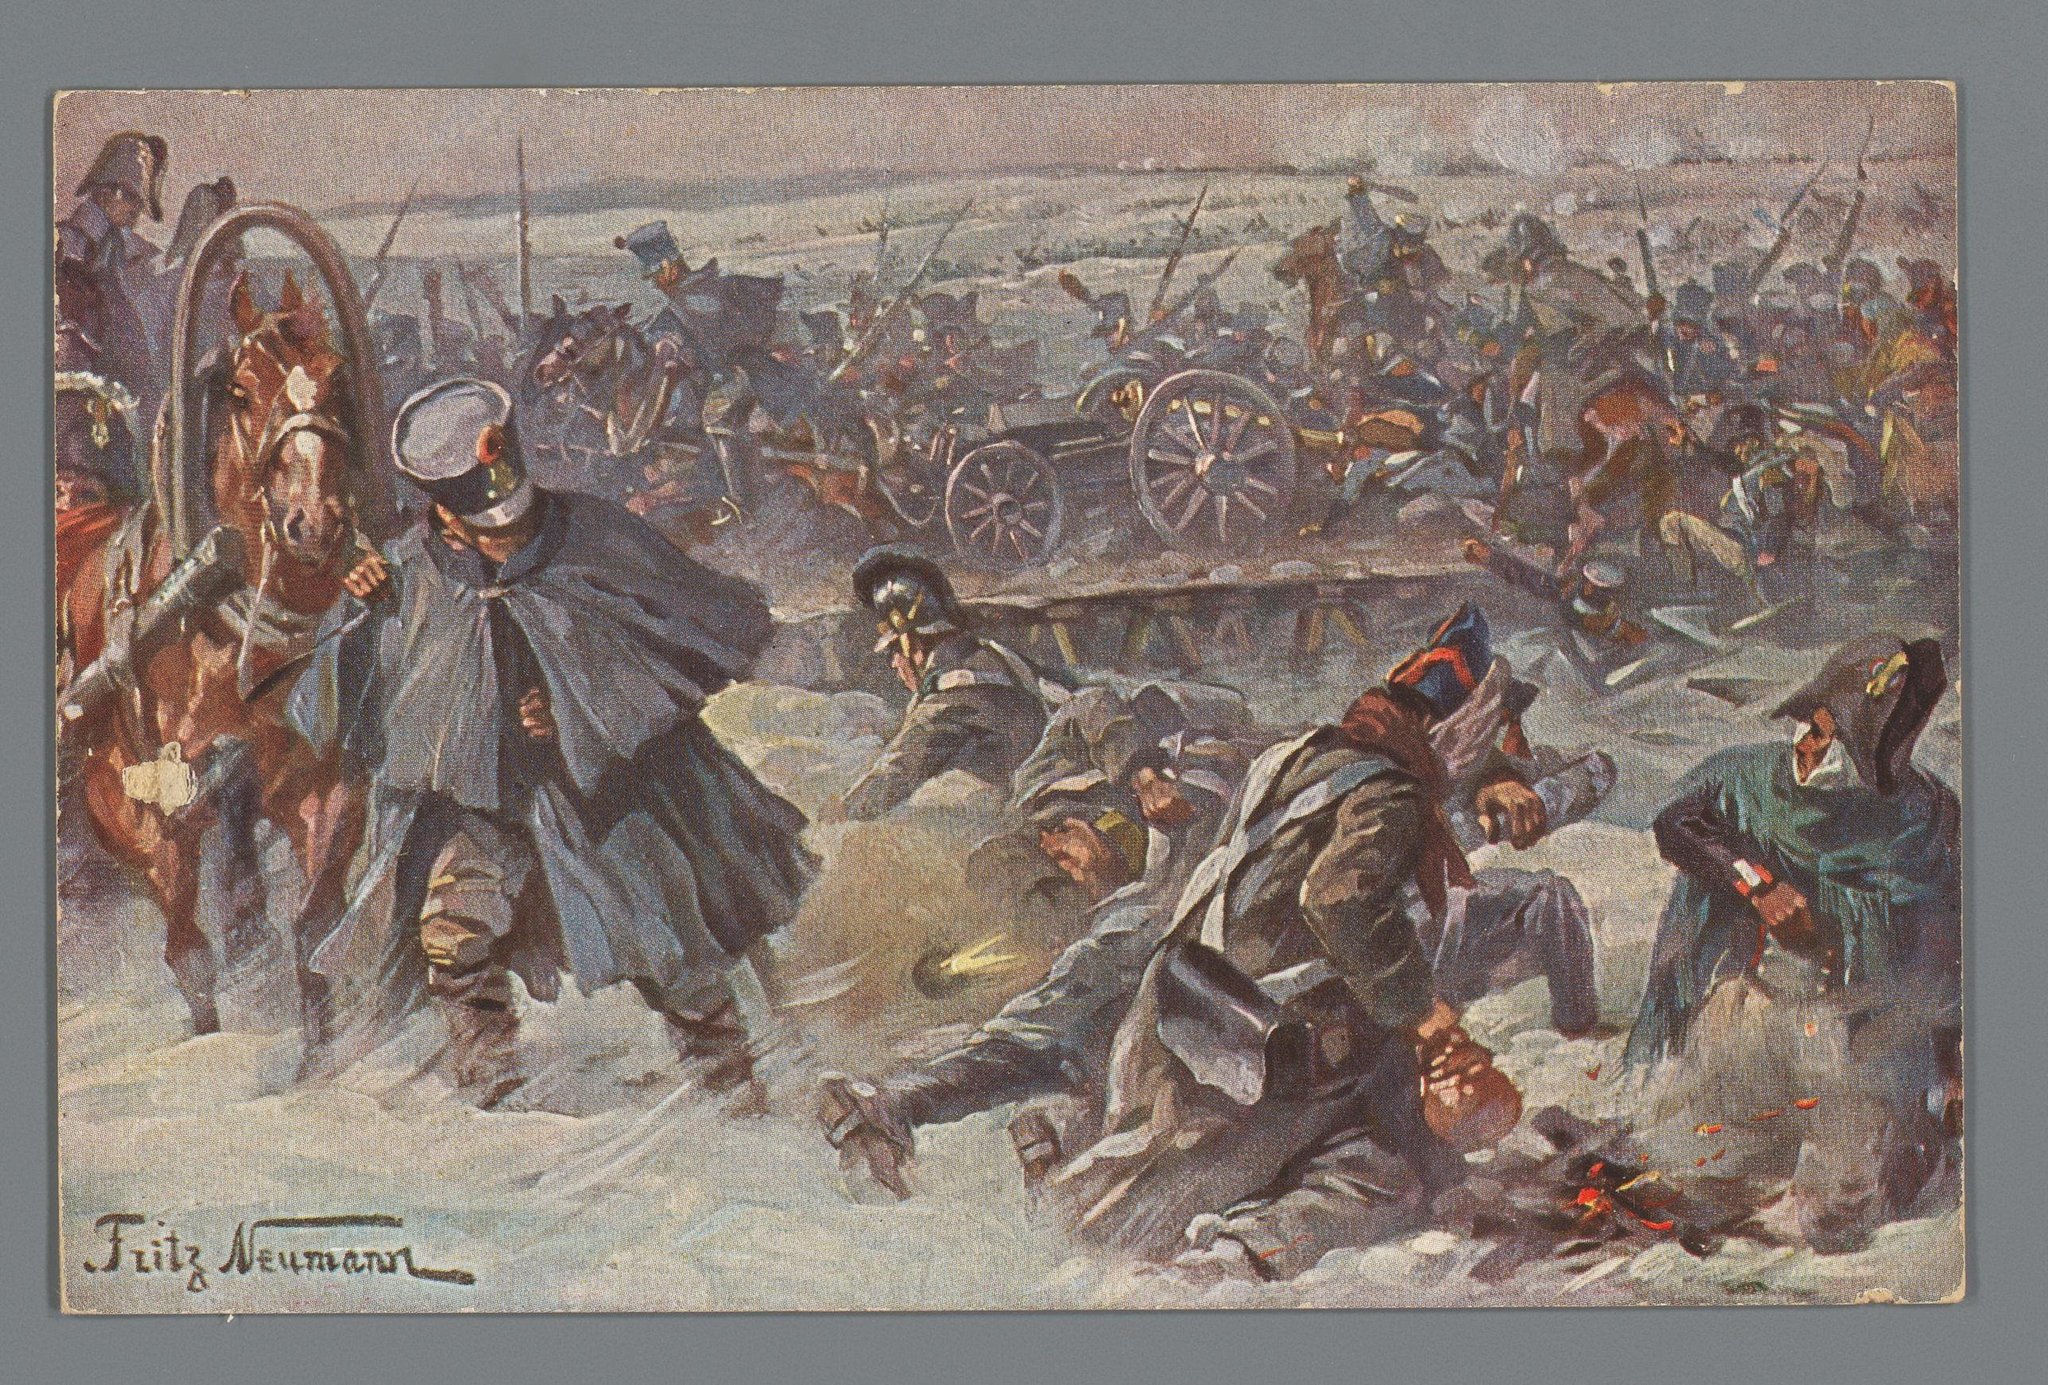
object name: photomechanical print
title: Gevecht tijdens de Slag aan de Berezina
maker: fritz neumann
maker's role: printer, publisher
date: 1905-1920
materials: cardboard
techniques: three-color autotype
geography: germany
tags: battle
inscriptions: inscription: ‘Marke E.G.M.S. Serie 105.’, inscription: ‘68, oorlog’, title: ‘1812 r. [Cyrillisch schrift]/ Passage de la Bérésina./ Uebergang über die Beresina.’